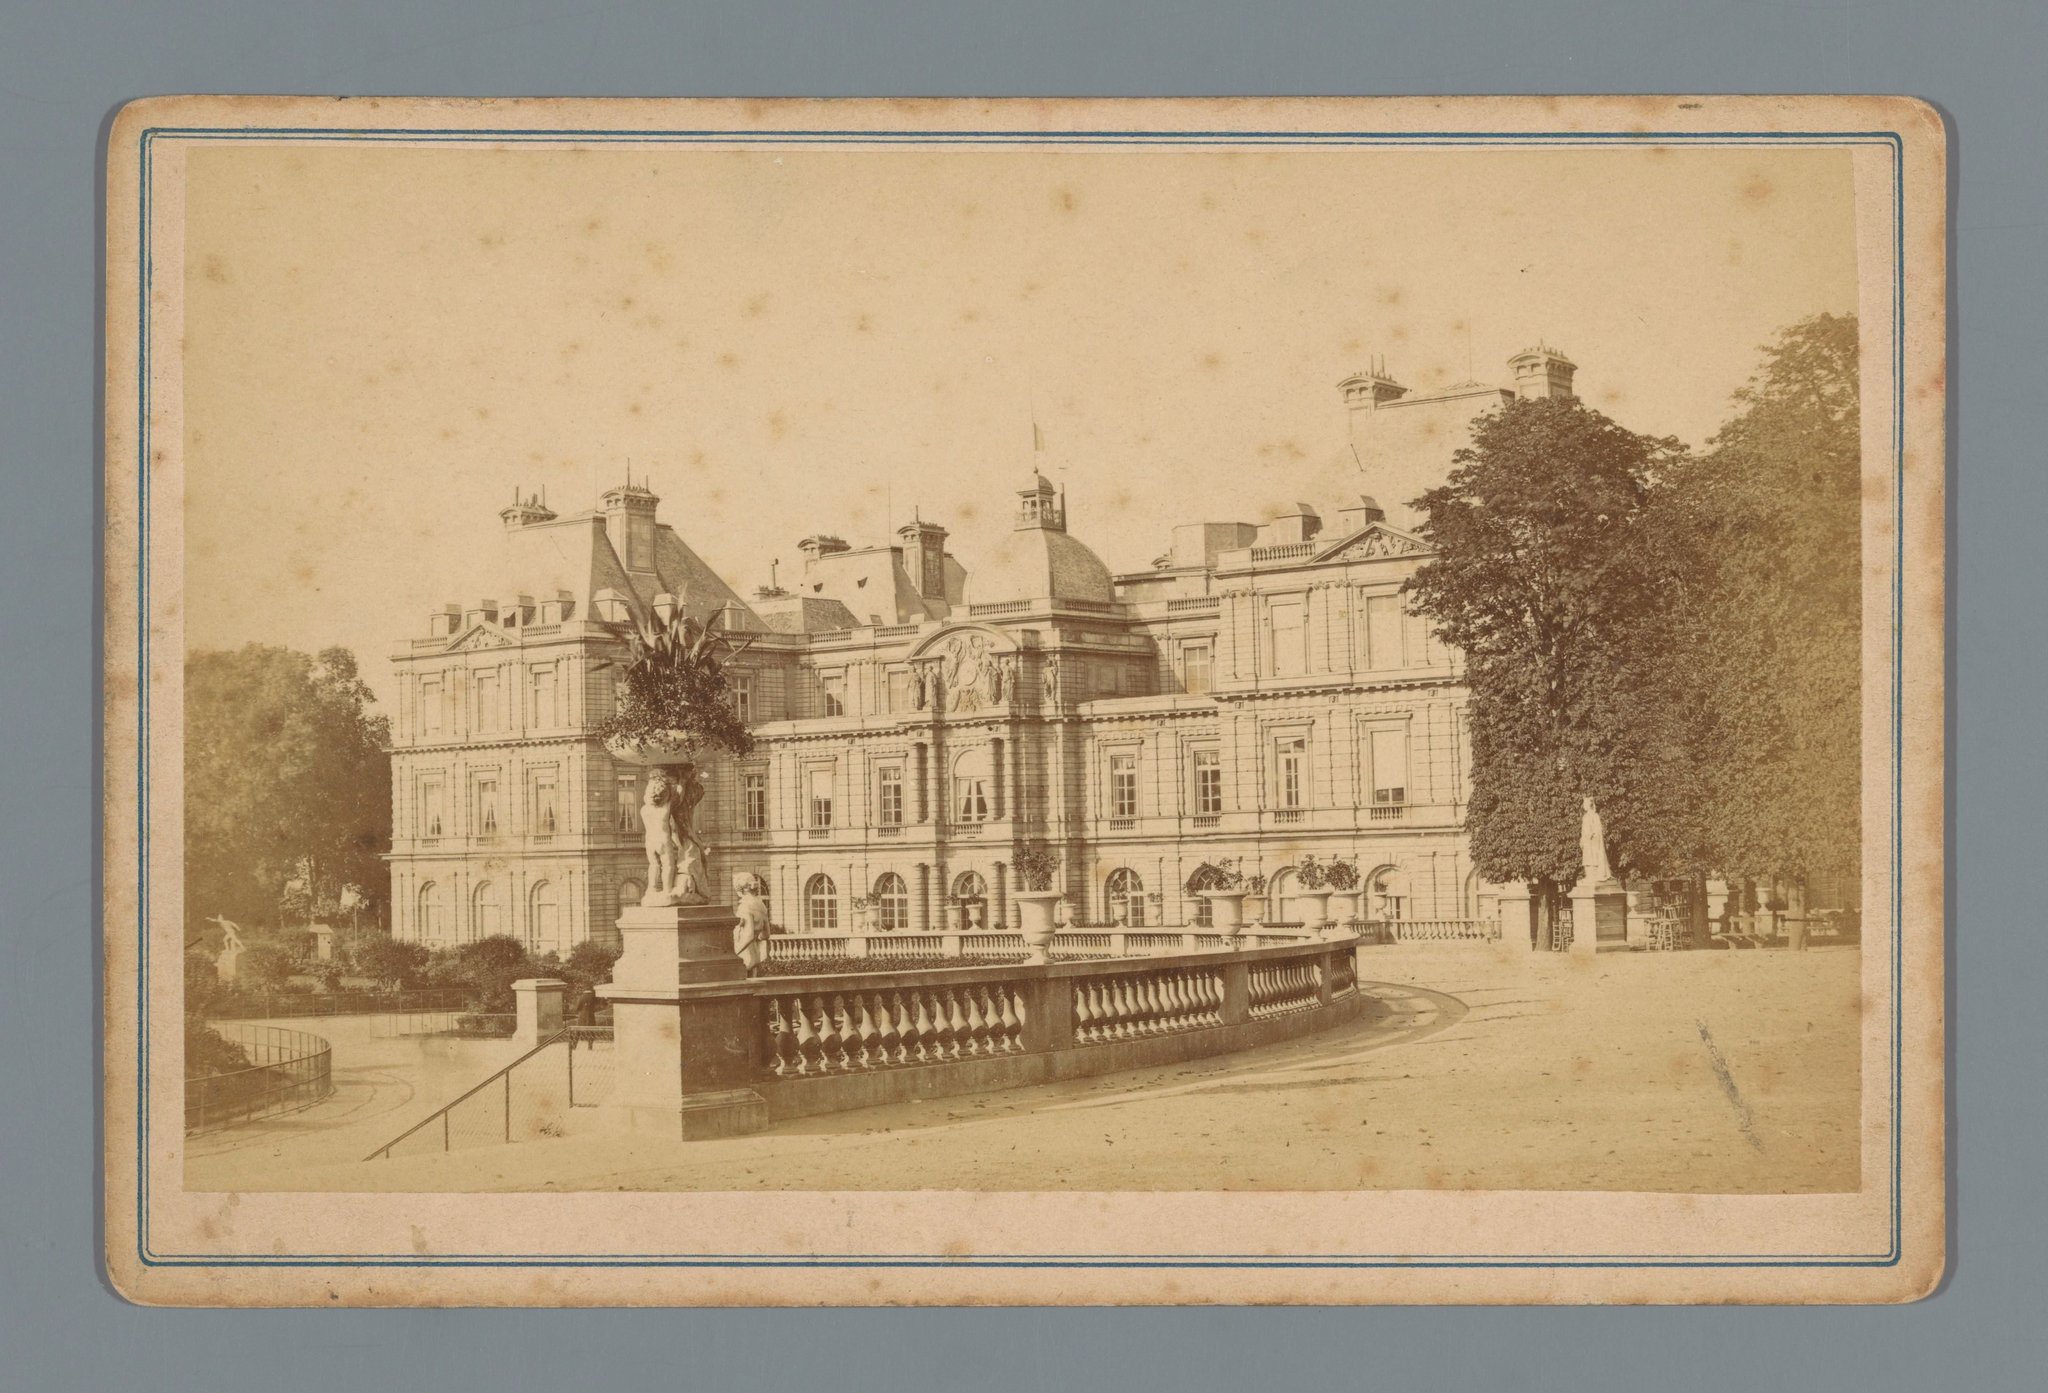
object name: photograph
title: Gezicht op het Palais du Luxembourg te Parijs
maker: Anonymous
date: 1860-1890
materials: cardboard, photographic support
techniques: albumen print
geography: paris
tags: palace, façade (of house or building), public gardens, park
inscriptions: annotation: ‘Museum de Luxembourg’